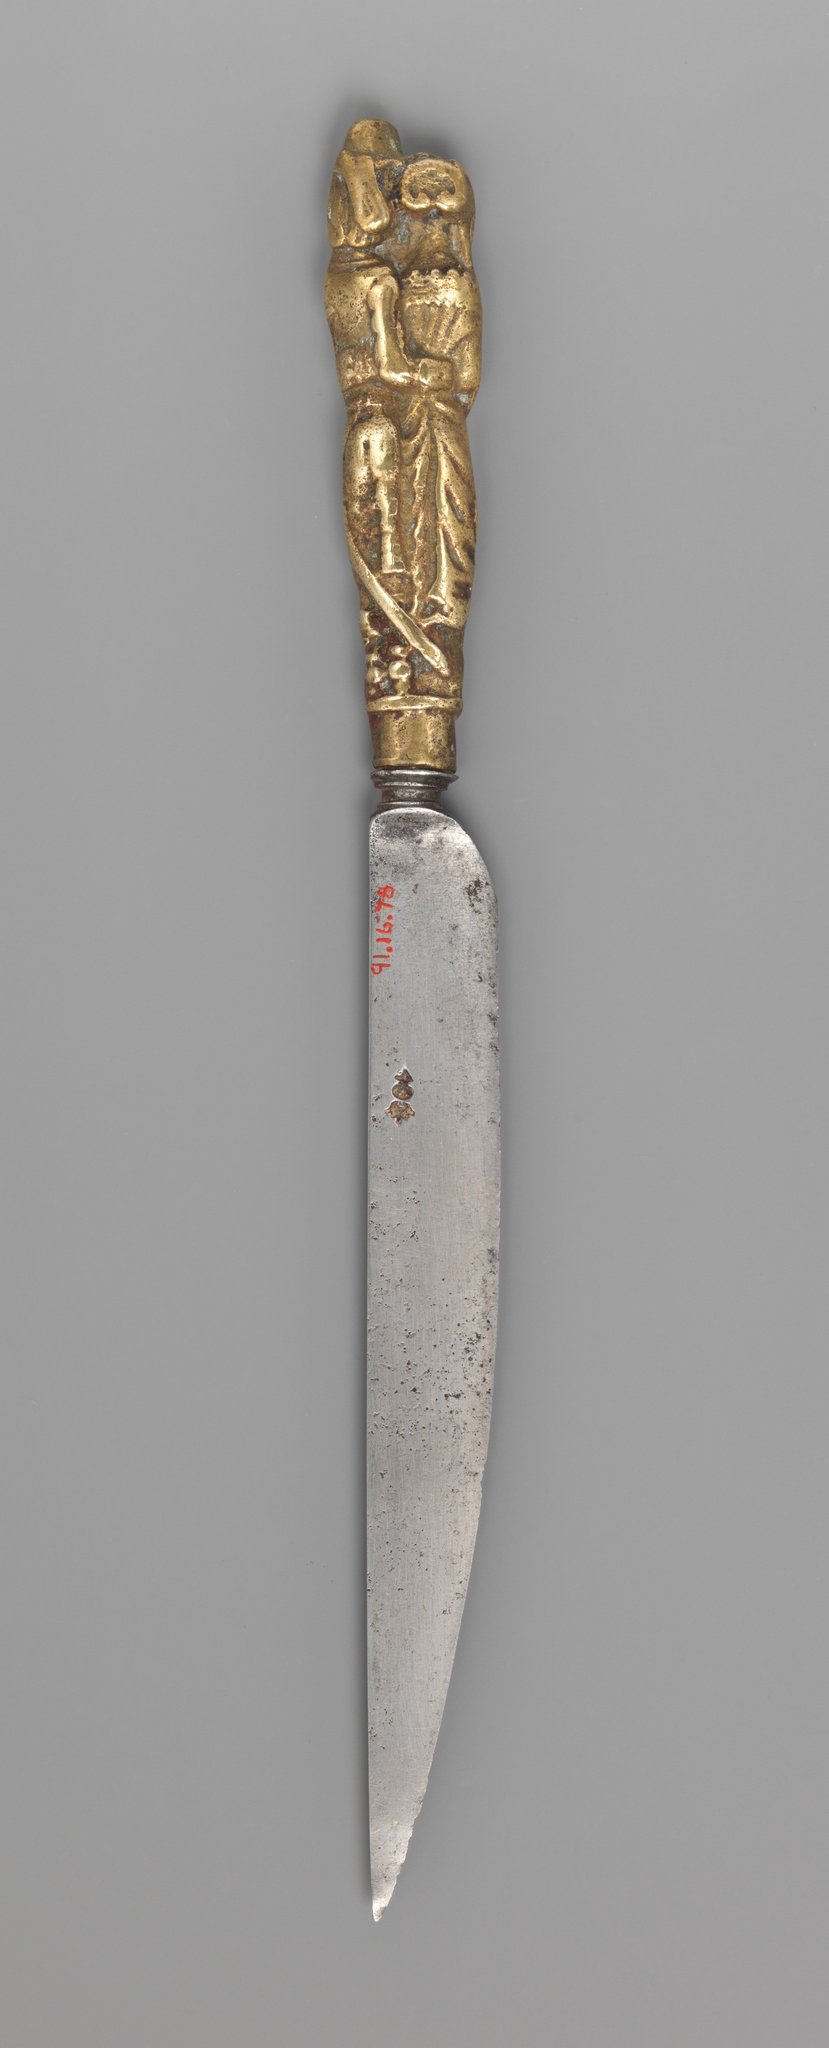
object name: table knife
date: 1601-1700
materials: steel